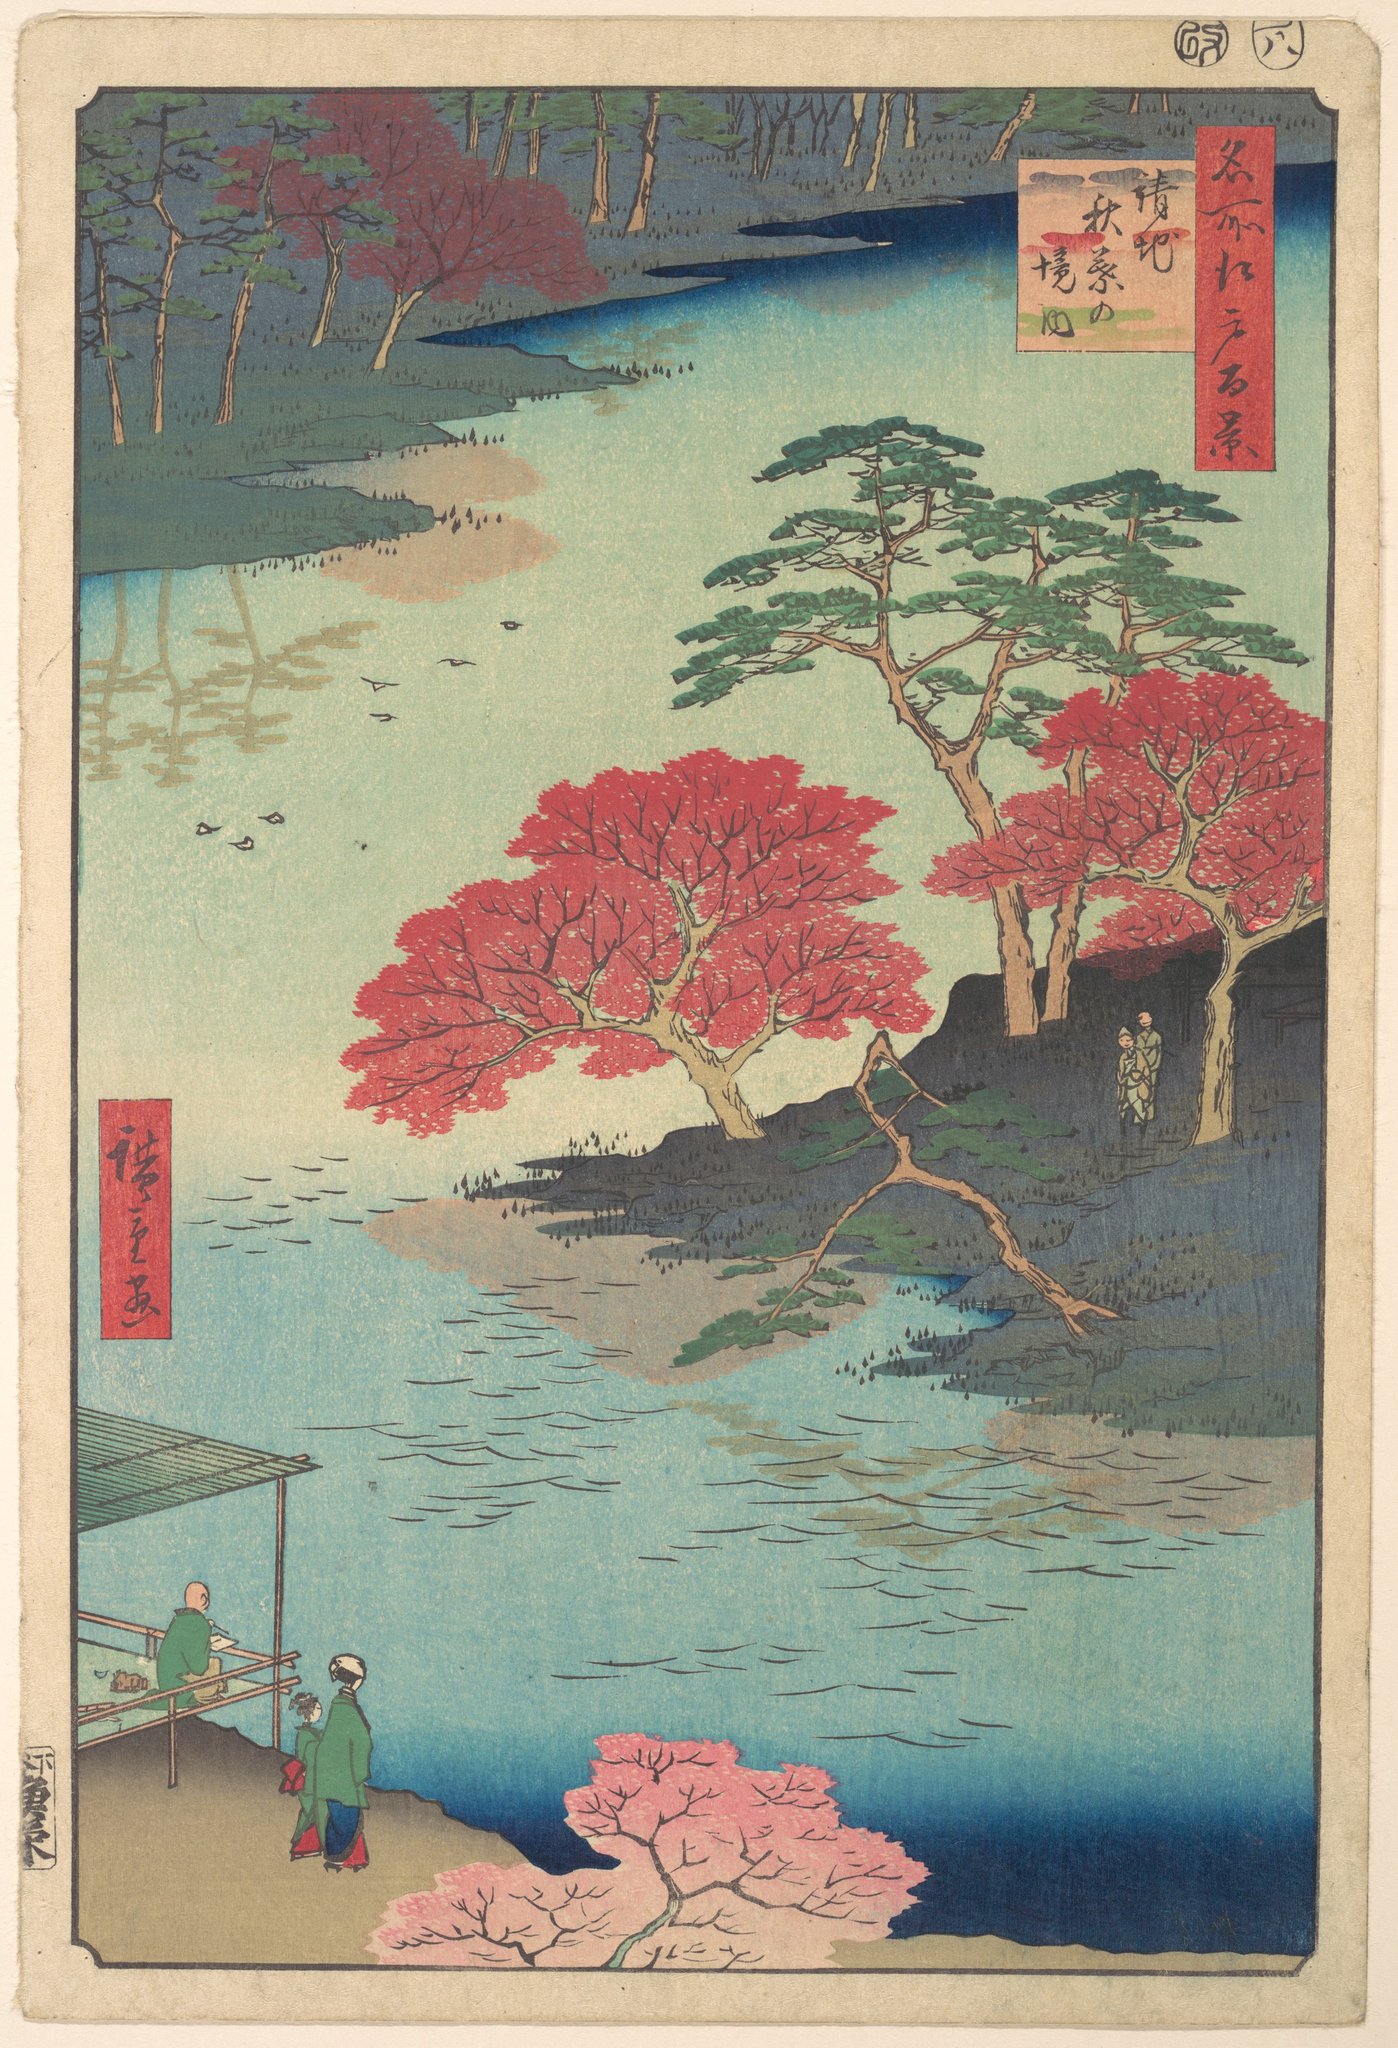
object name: print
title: Inside Akiba Shrine at Ukeji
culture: japanese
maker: utagawa hiroshige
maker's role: artist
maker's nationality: japanese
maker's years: 1797-1858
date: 1857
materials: ink, paper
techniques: woodblock print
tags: rivers,landscapes